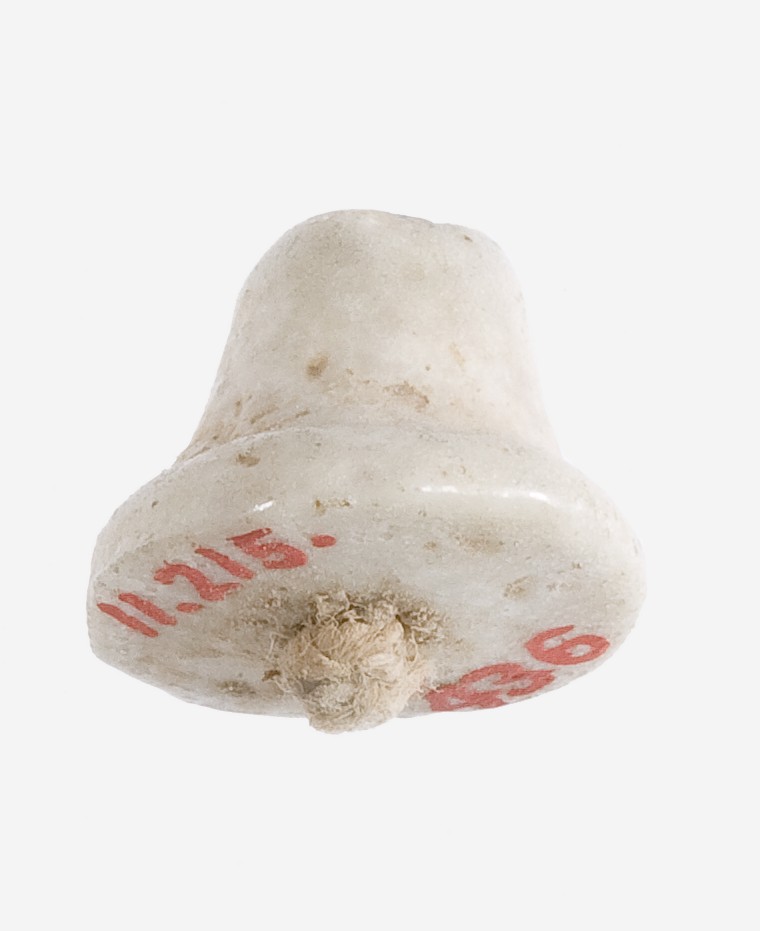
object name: pendant, umbel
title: Umbel Pendant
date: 1390-1352 BCE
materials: faience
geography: egypt